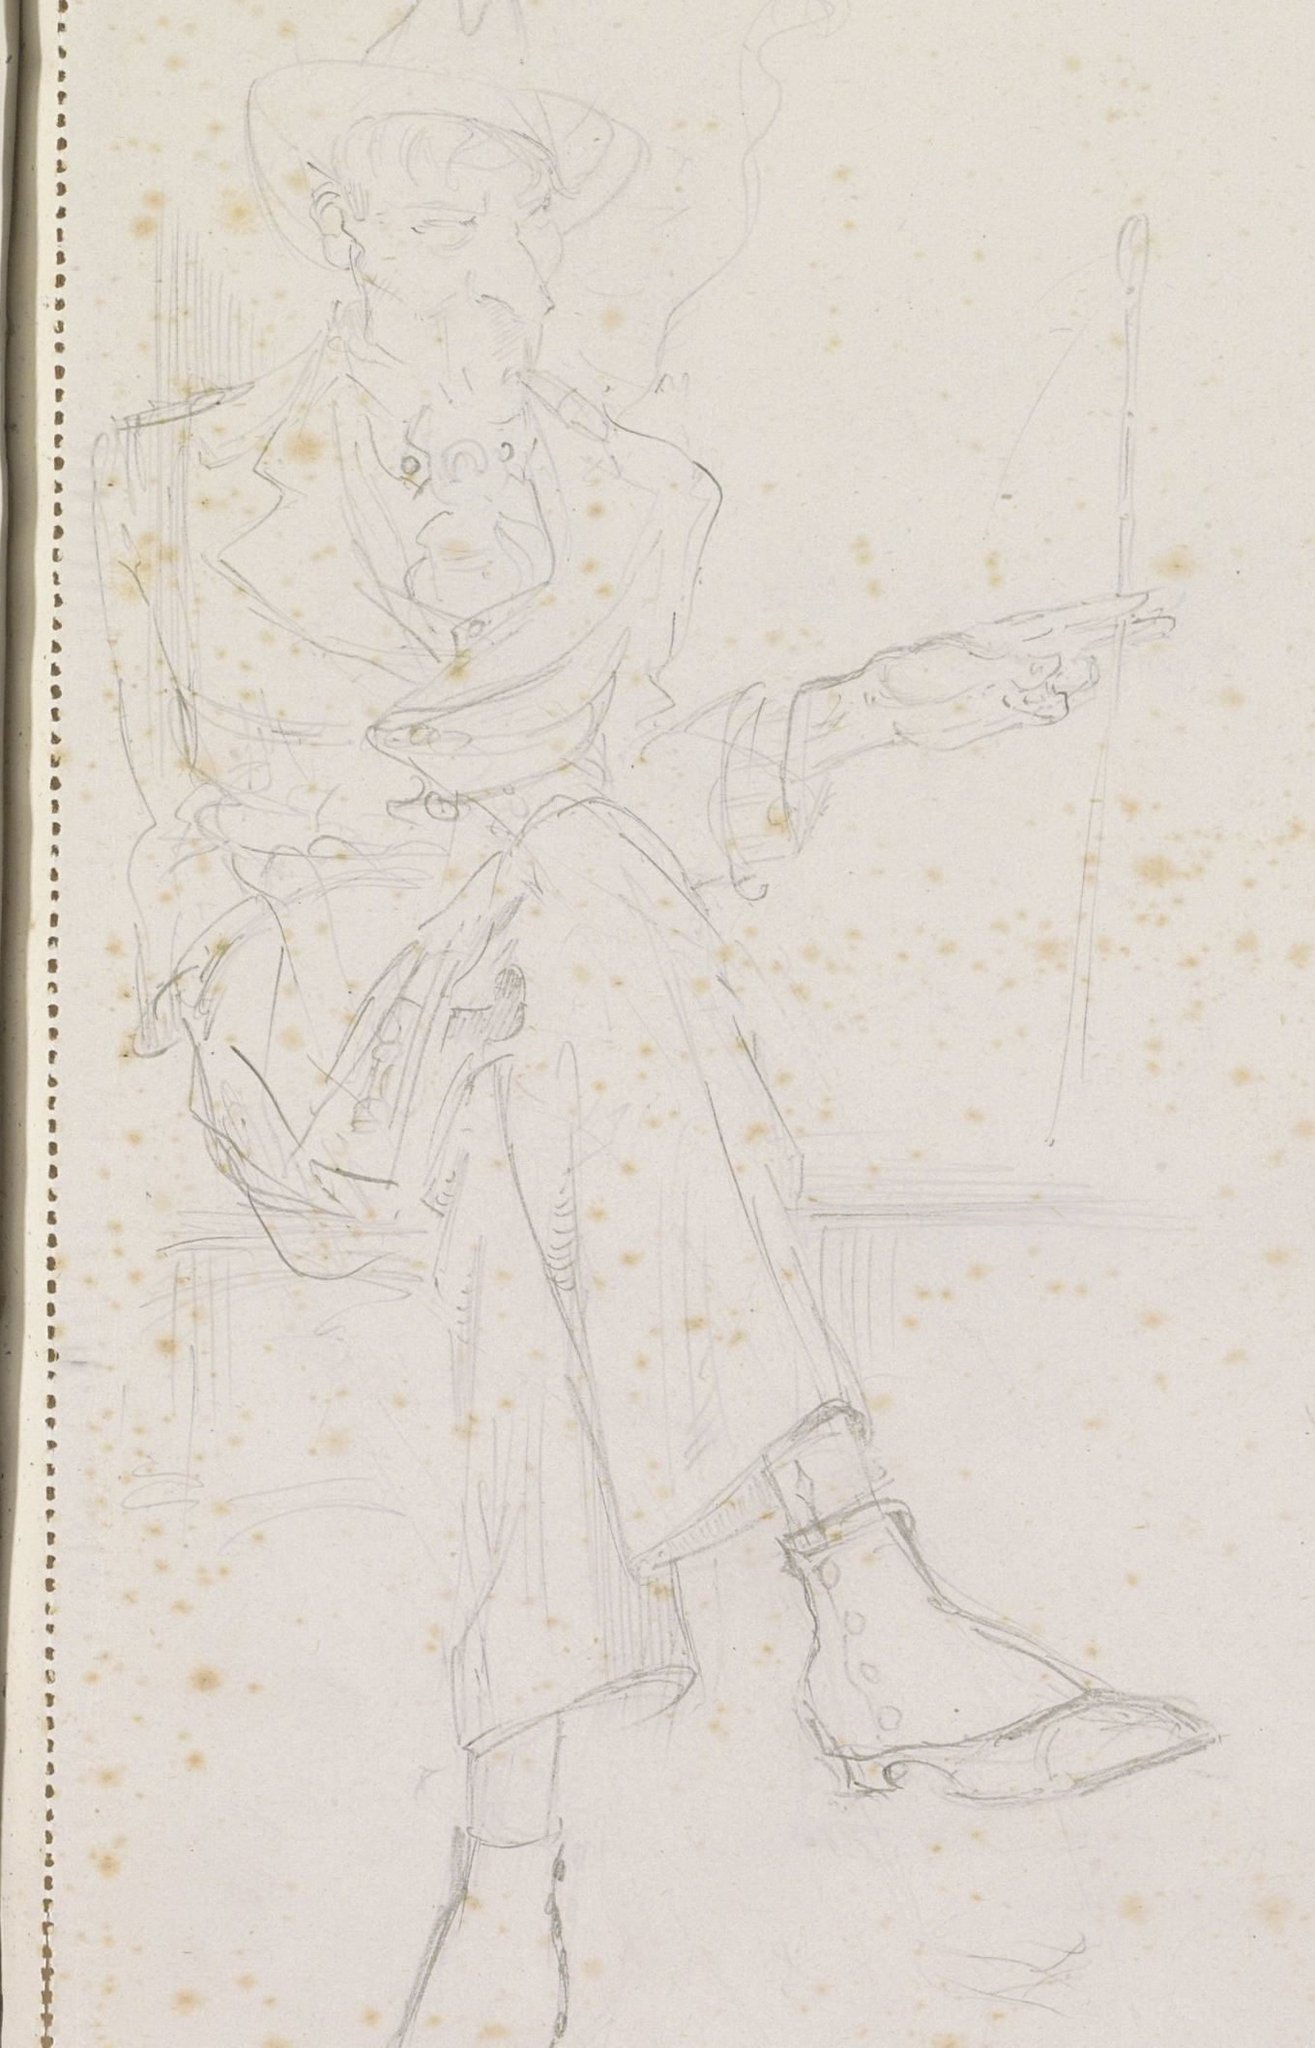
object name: sketchbook leaf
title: Zittende man met een sigaar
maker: otto verhagen (i)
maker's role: draughtsman, print maker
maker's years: 1885-1951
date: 1922-1925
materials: paper, pencil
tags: sitting figure, cigar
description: De man draagt een pak, laarzen en een hoed en wijst met zijn linkerhand opzij. Pagina 6 uit een schetsboek met 34 bladen.